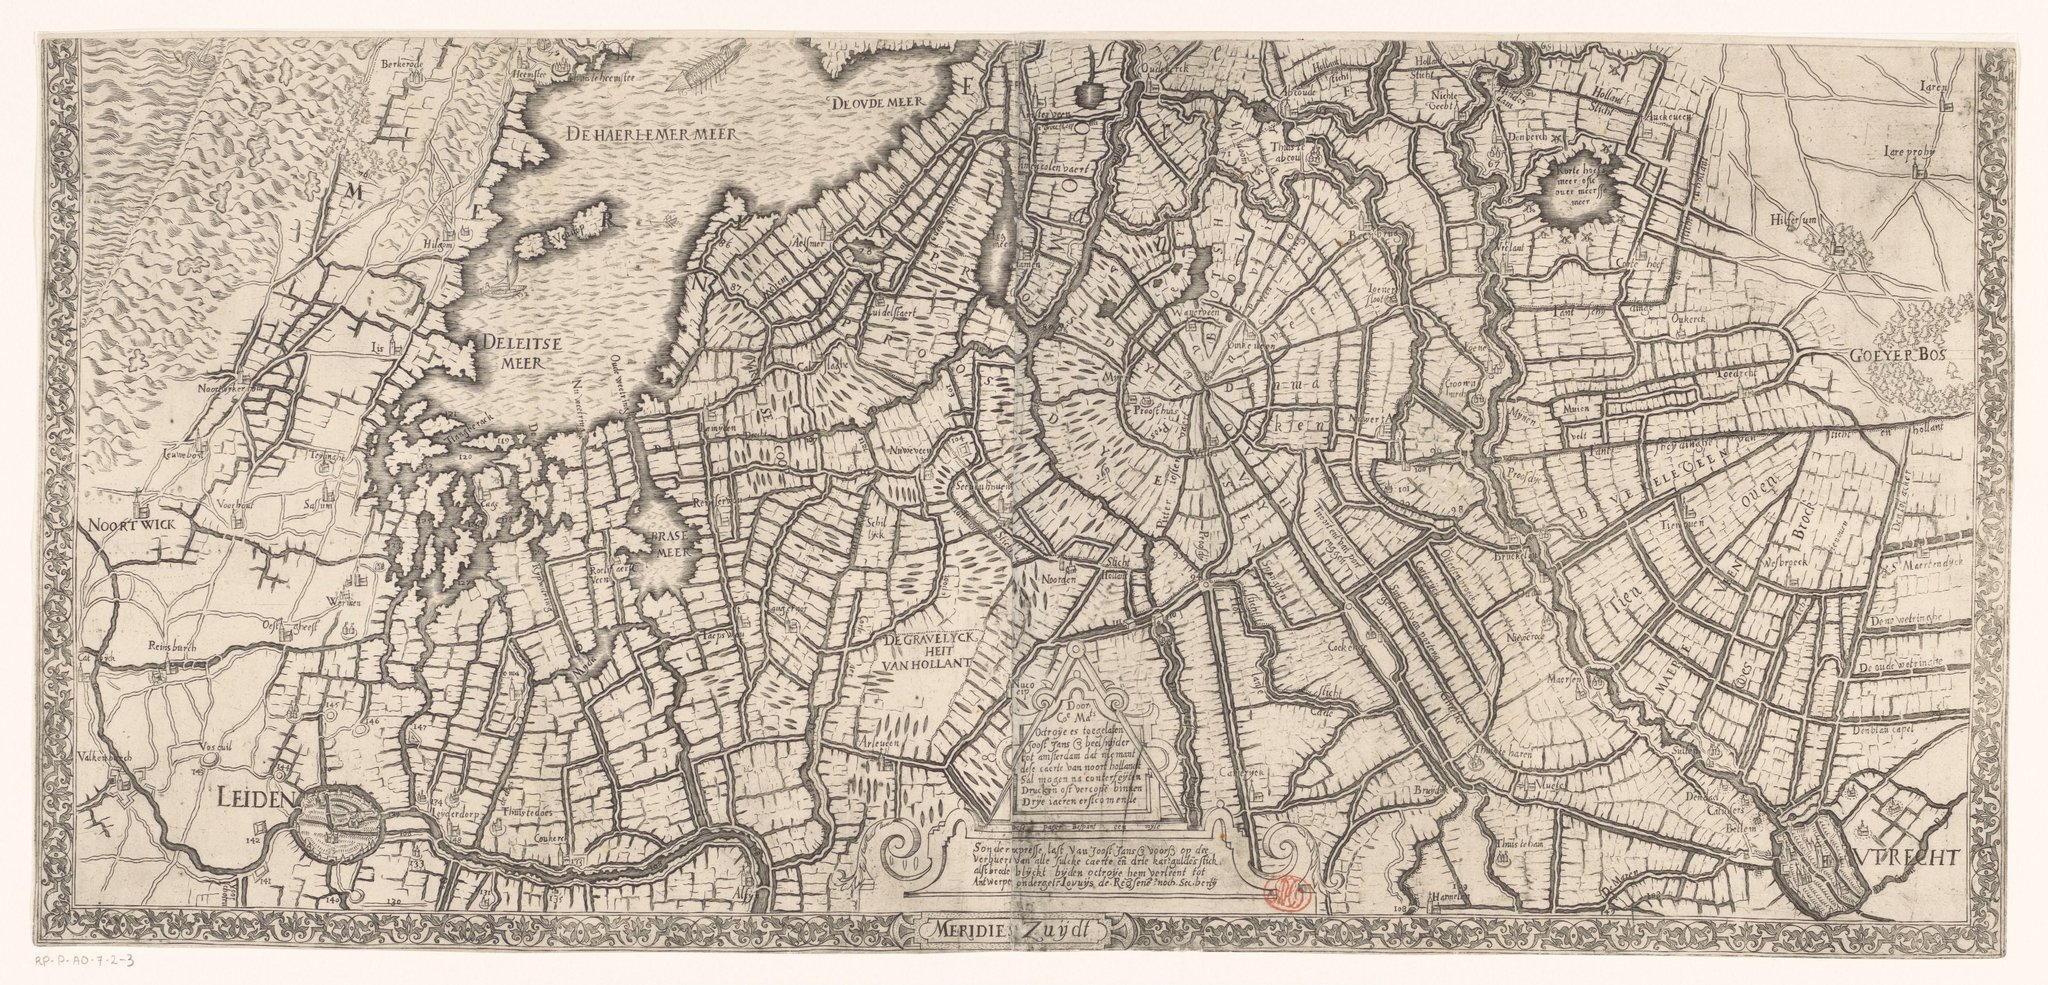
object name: map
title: Kaart van Noord-Holland (onderste deel)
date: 1575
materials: paper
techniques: engraving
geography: amsterdam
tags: maps of separate countries or regions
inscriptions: collector's mark: Lugt 195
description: Van de eerste staat van deze kaart, die in 1575 werd uitgegeven door Joost Jansz. Bilhamer (ook wel Joost Jansz. Beeldsnijder of Bilham genoemd), zijn geen exemplaren bekend. De huidige staat werd in 1608 uitgegeven door Herman Allertsz. Koster van Warmenhuizen. Bij deze uitgave hoort een sierrand, voorzien van een uitgebreide historische en contemporaine beschrijving van het gebied in boekdruk en etsen gemaakt door Claes Jansz. Visscher (II).